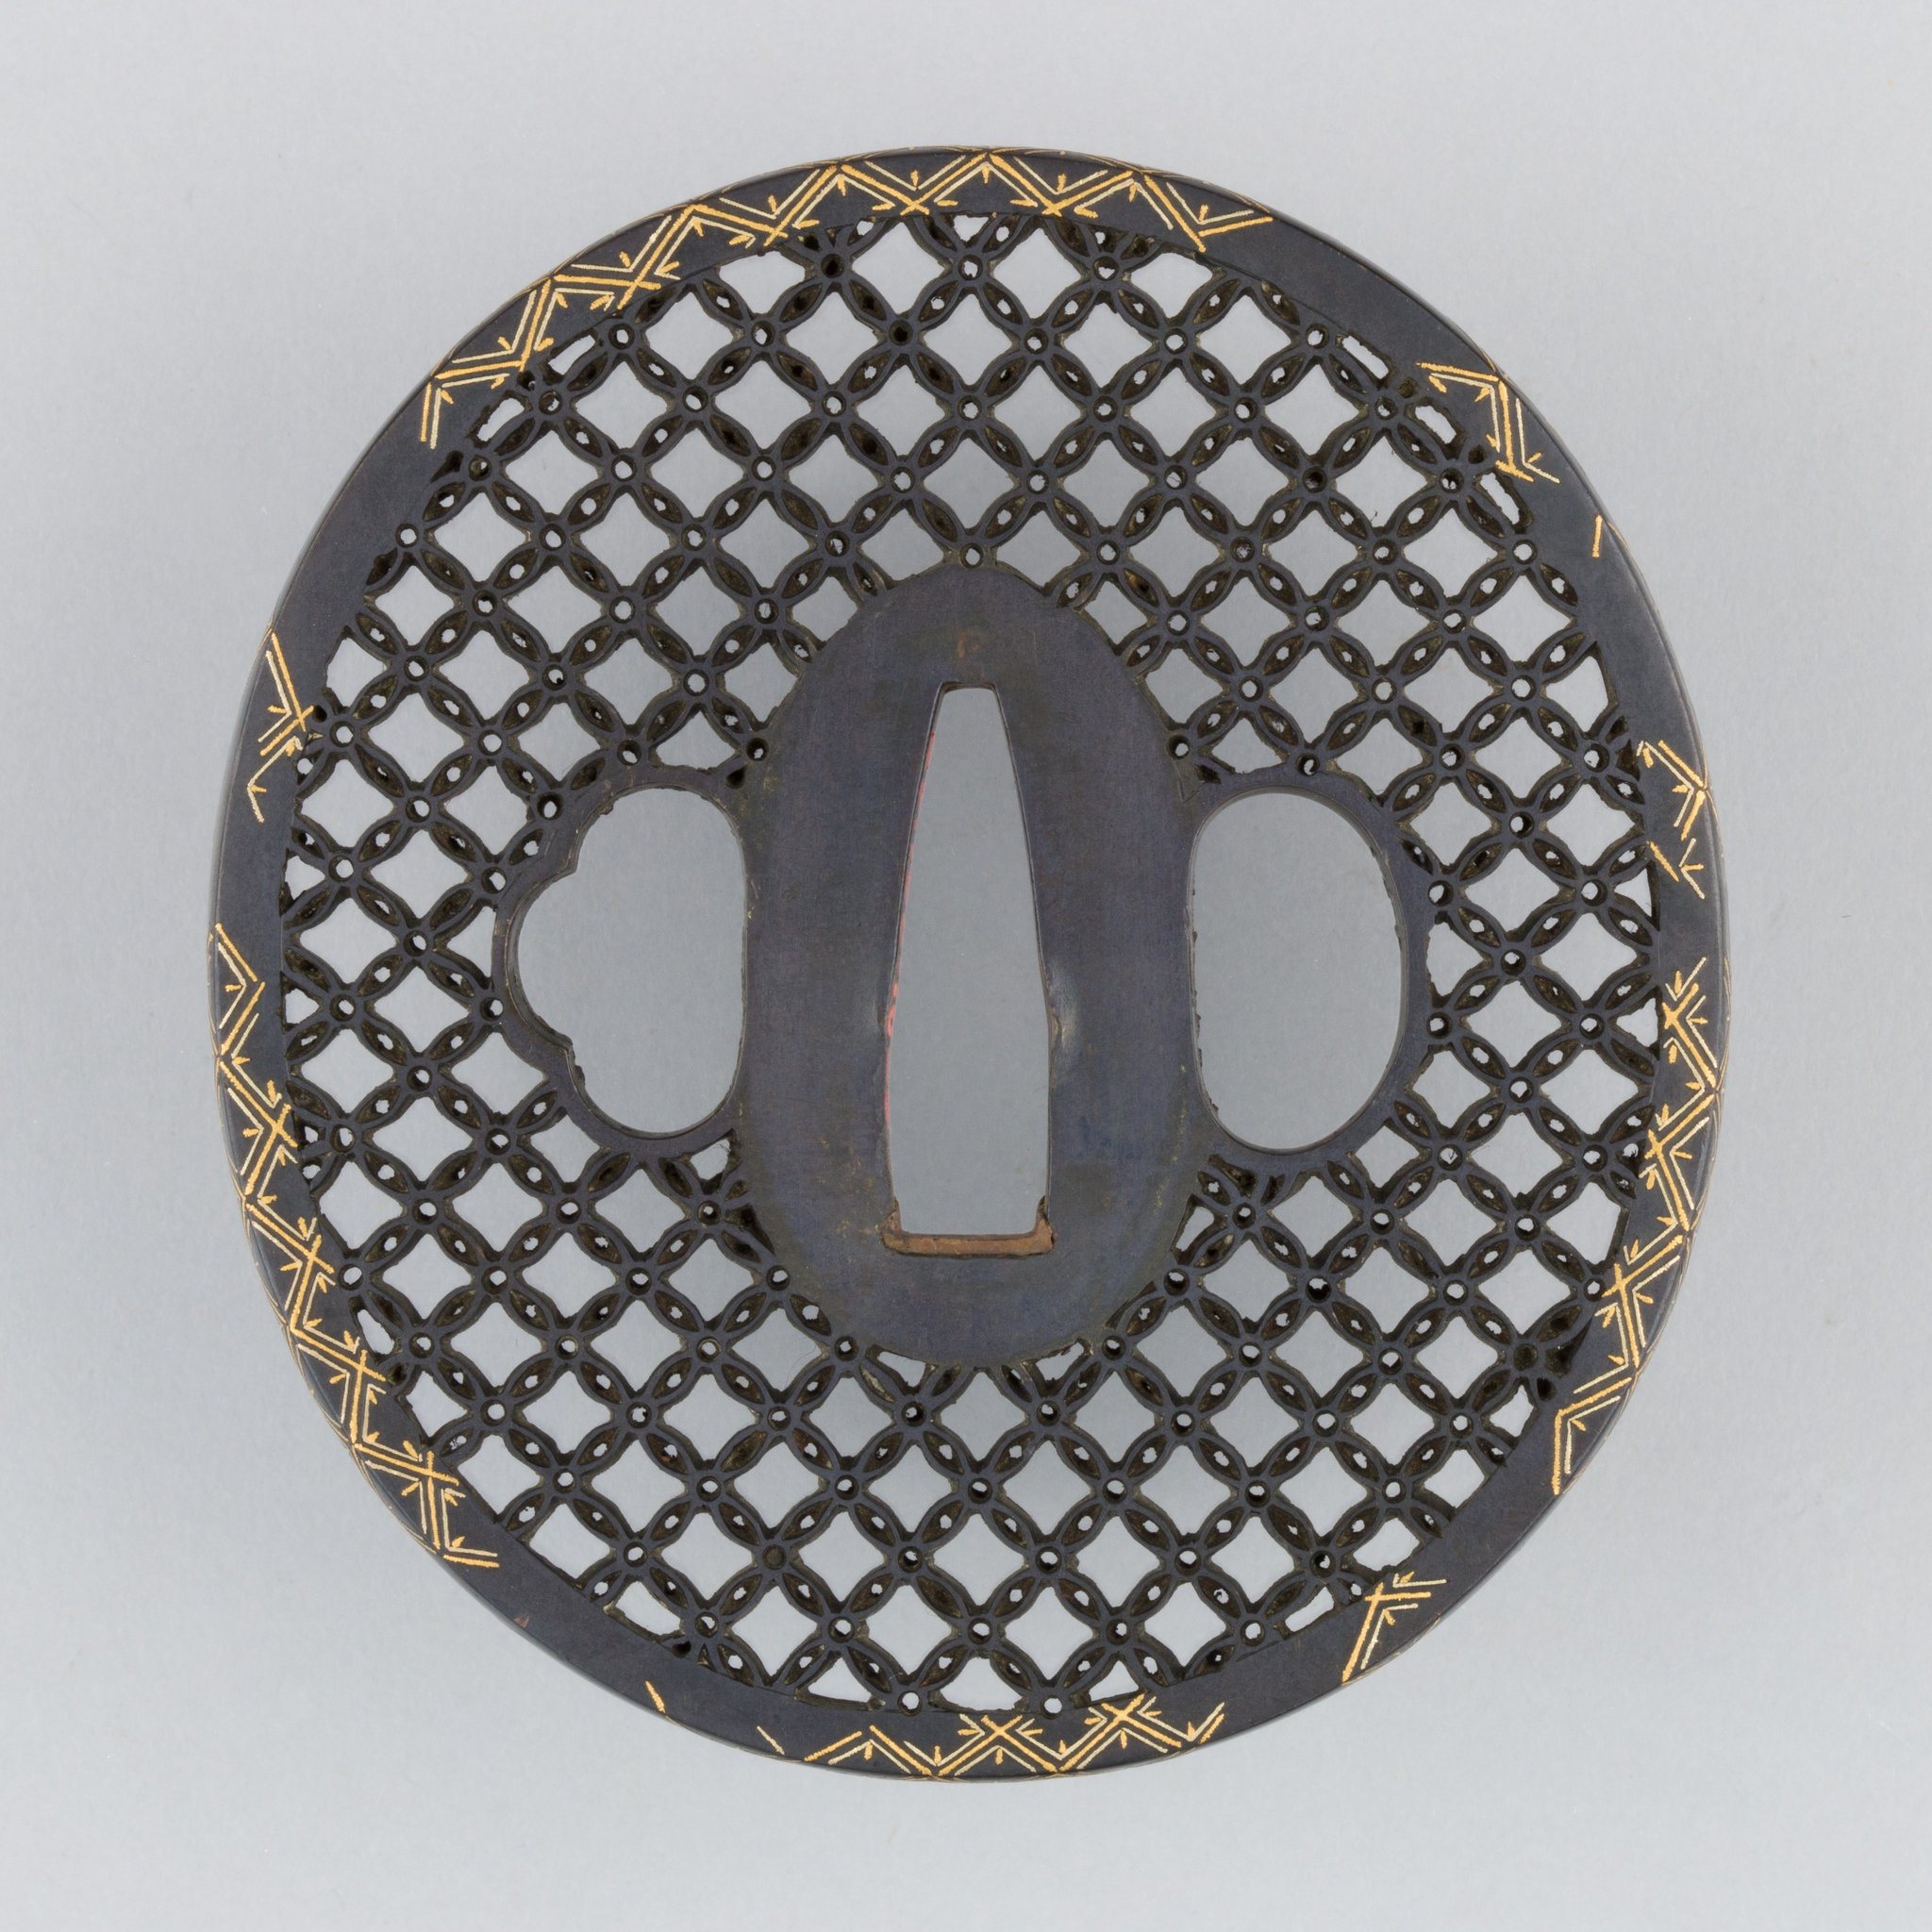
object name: sword guard tsuba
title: Sword Guard (Tsuba)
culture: japanese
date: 1615-1868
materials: copper, gold alloy, gold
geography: japan